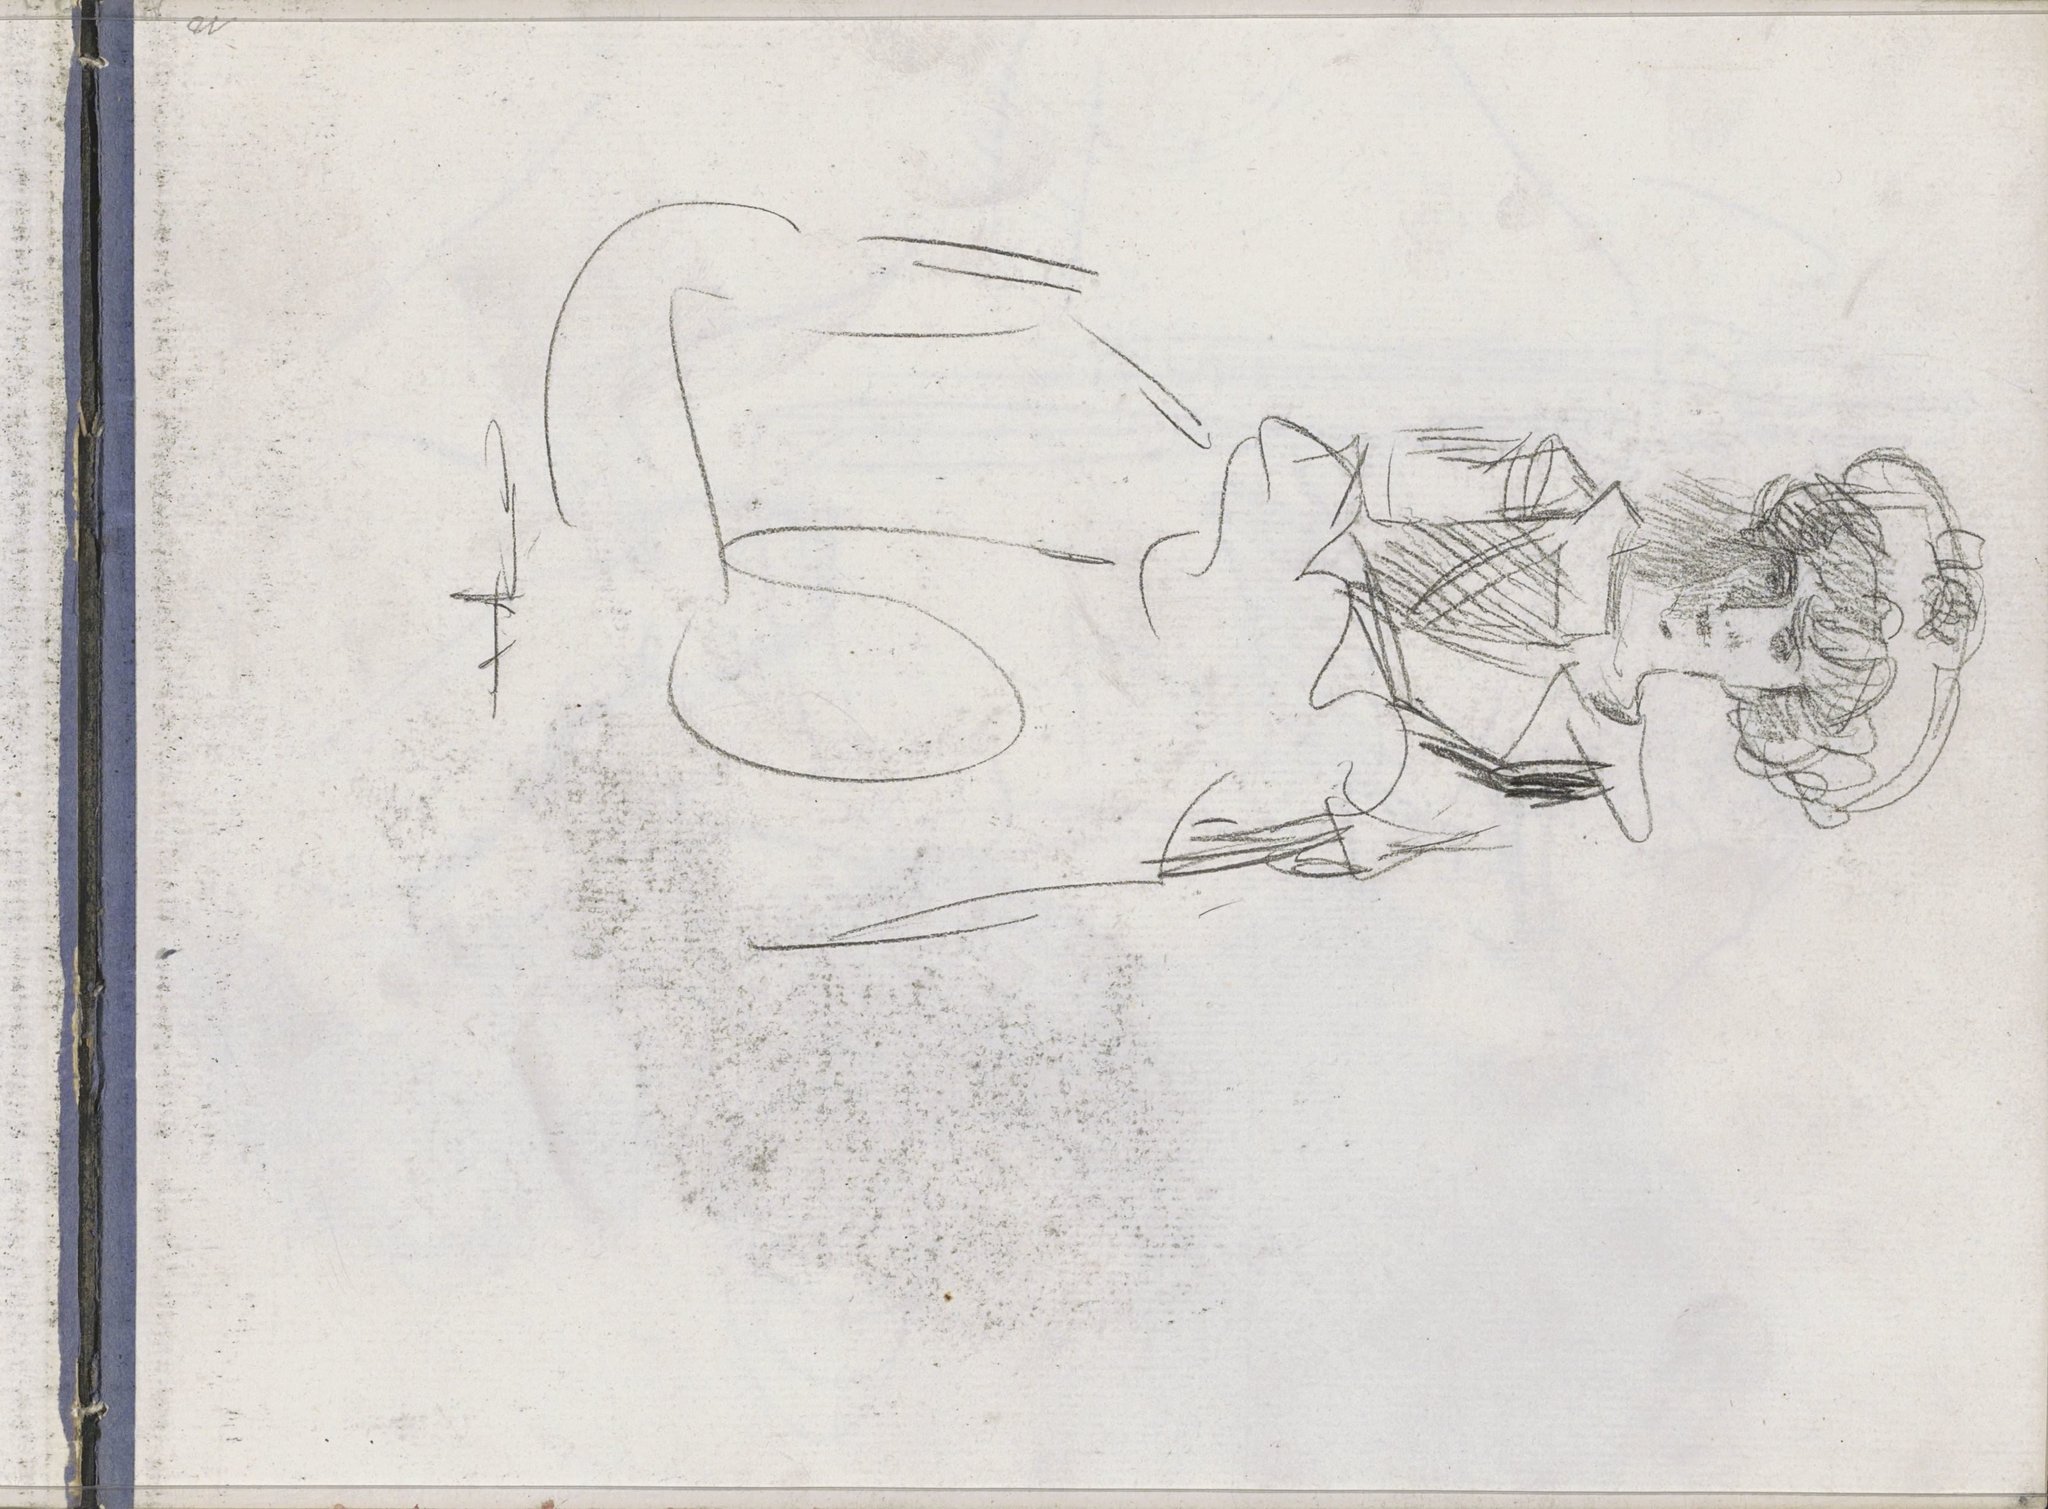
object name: sketchbook leaf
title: Staande vrouw met hoed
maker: isaac israels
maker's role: draughtsman, painter, print maker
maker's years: 1865-1934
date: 1875-1934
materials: chalk, paper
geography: the hague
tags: head-gear: hat (+ women's clothes), adult woman (+ standing)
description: Blad 22 recto uit schetsboek XXII met 30 bladen.